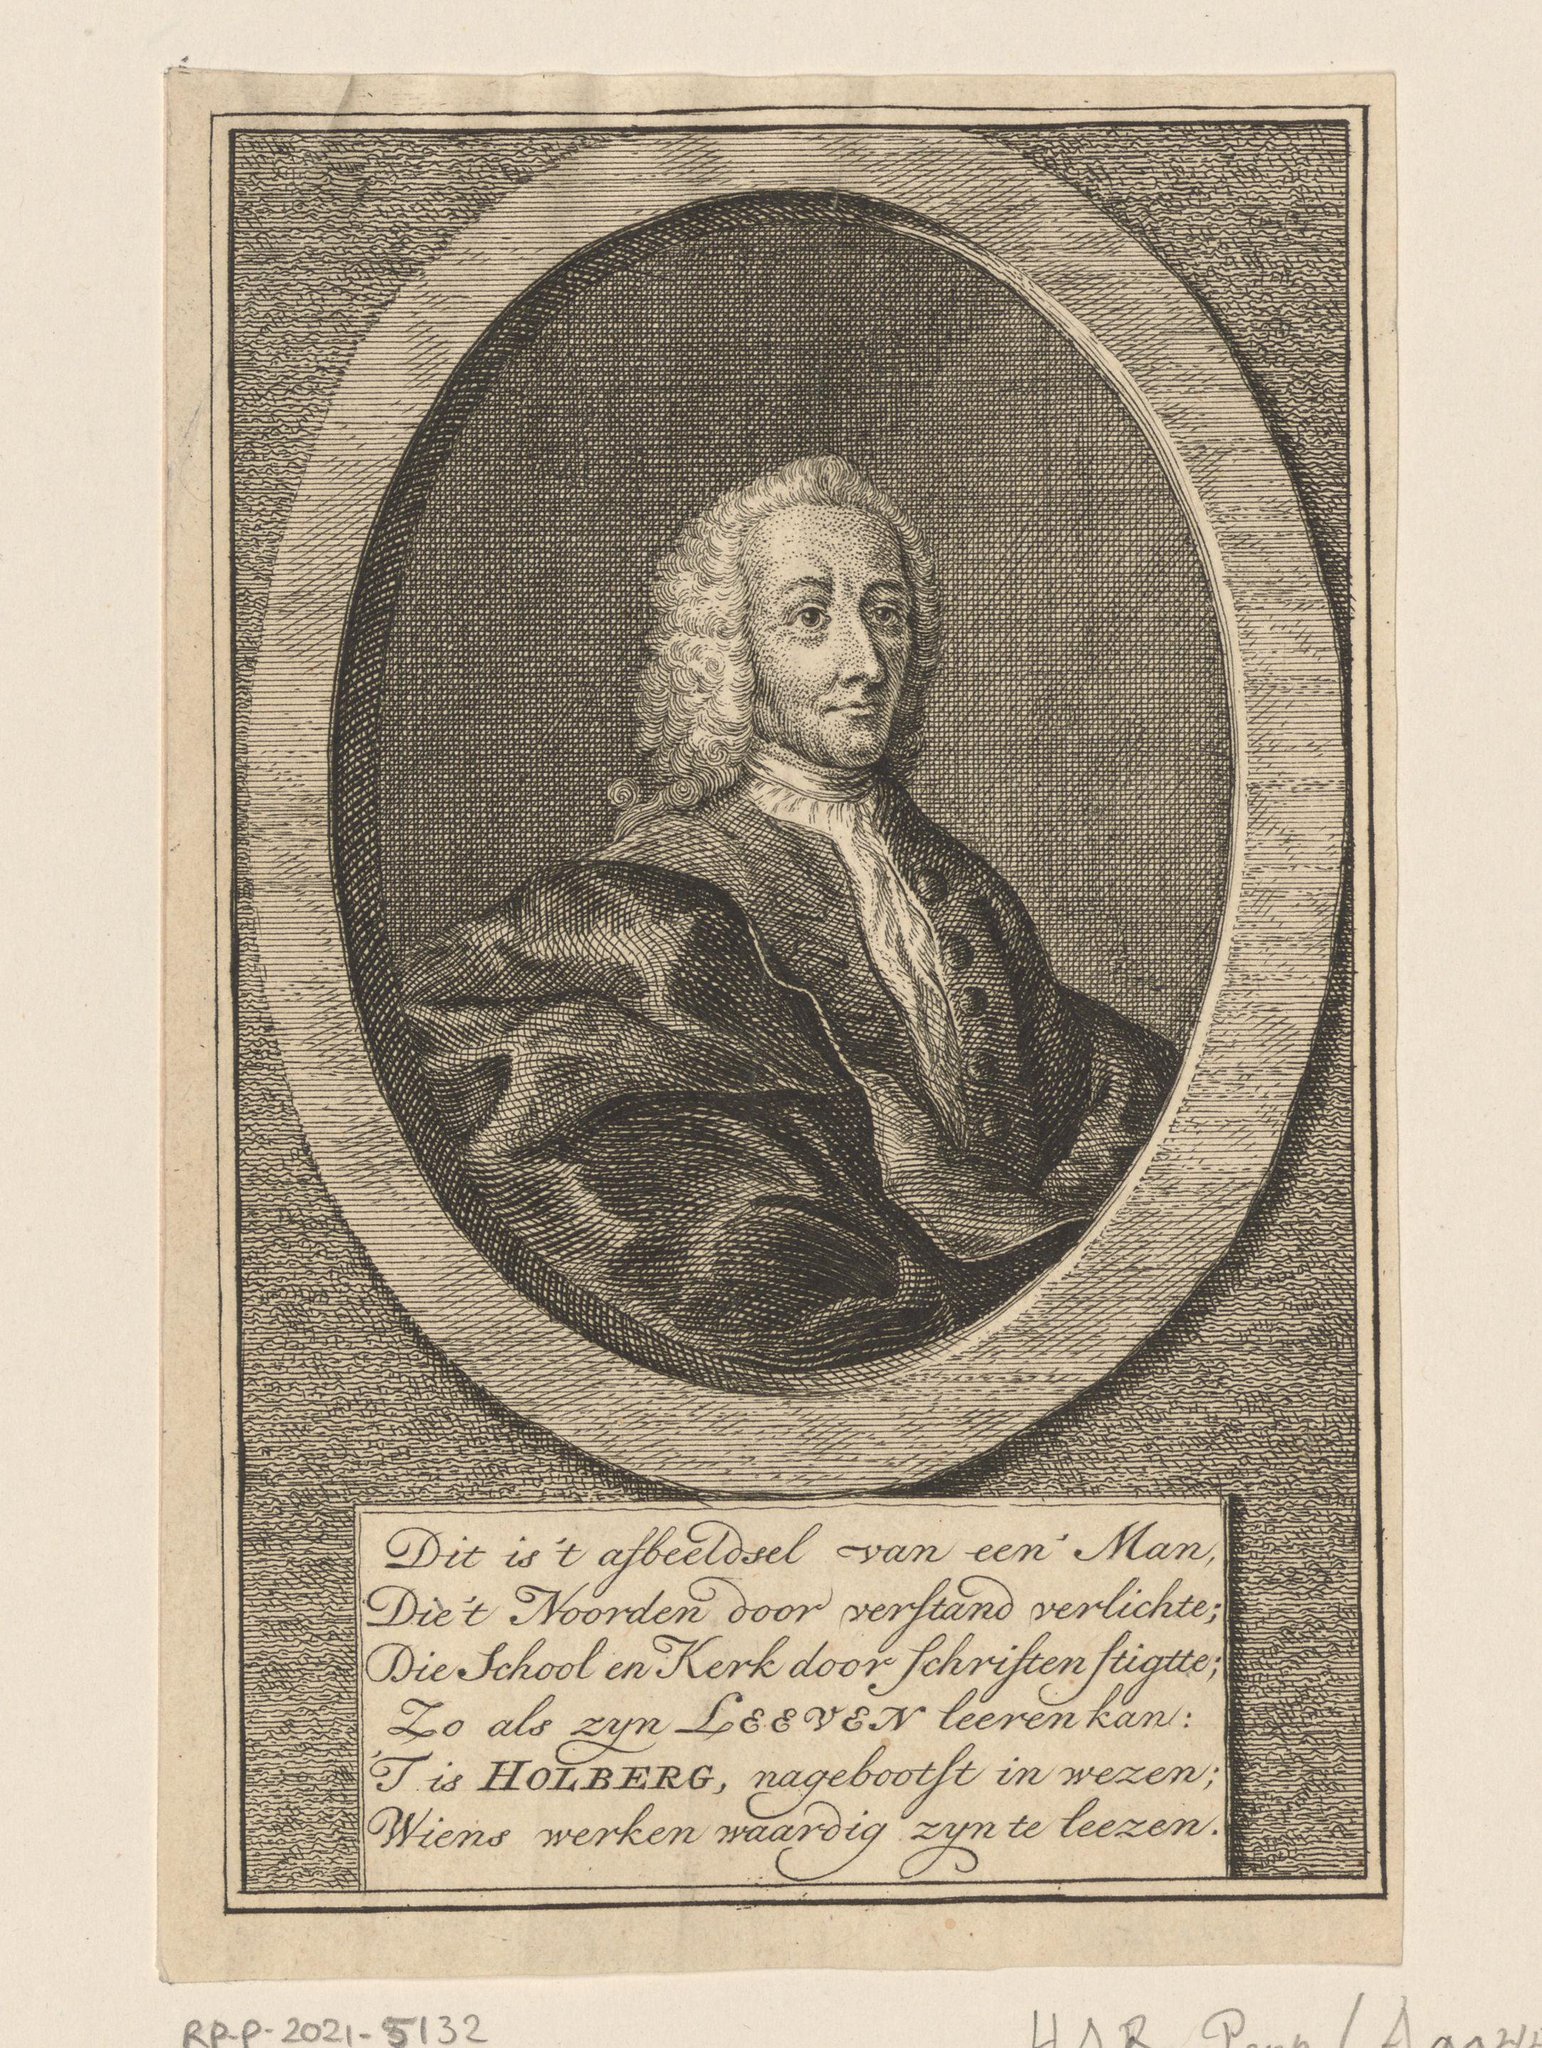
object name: book illustration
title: Portret van Ludvig Holberg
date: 1765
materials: paper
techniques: engraving, etching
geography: amsterdam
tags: historical persons, portrait of a writer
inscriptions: collector's mark: Lugt 2228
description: Prent uit: Holberg, Ludvig. Leevensbeschrijving van den heere baron Lodewijk Holberg. Amsterdam: Steven van Esveldt, 1765.